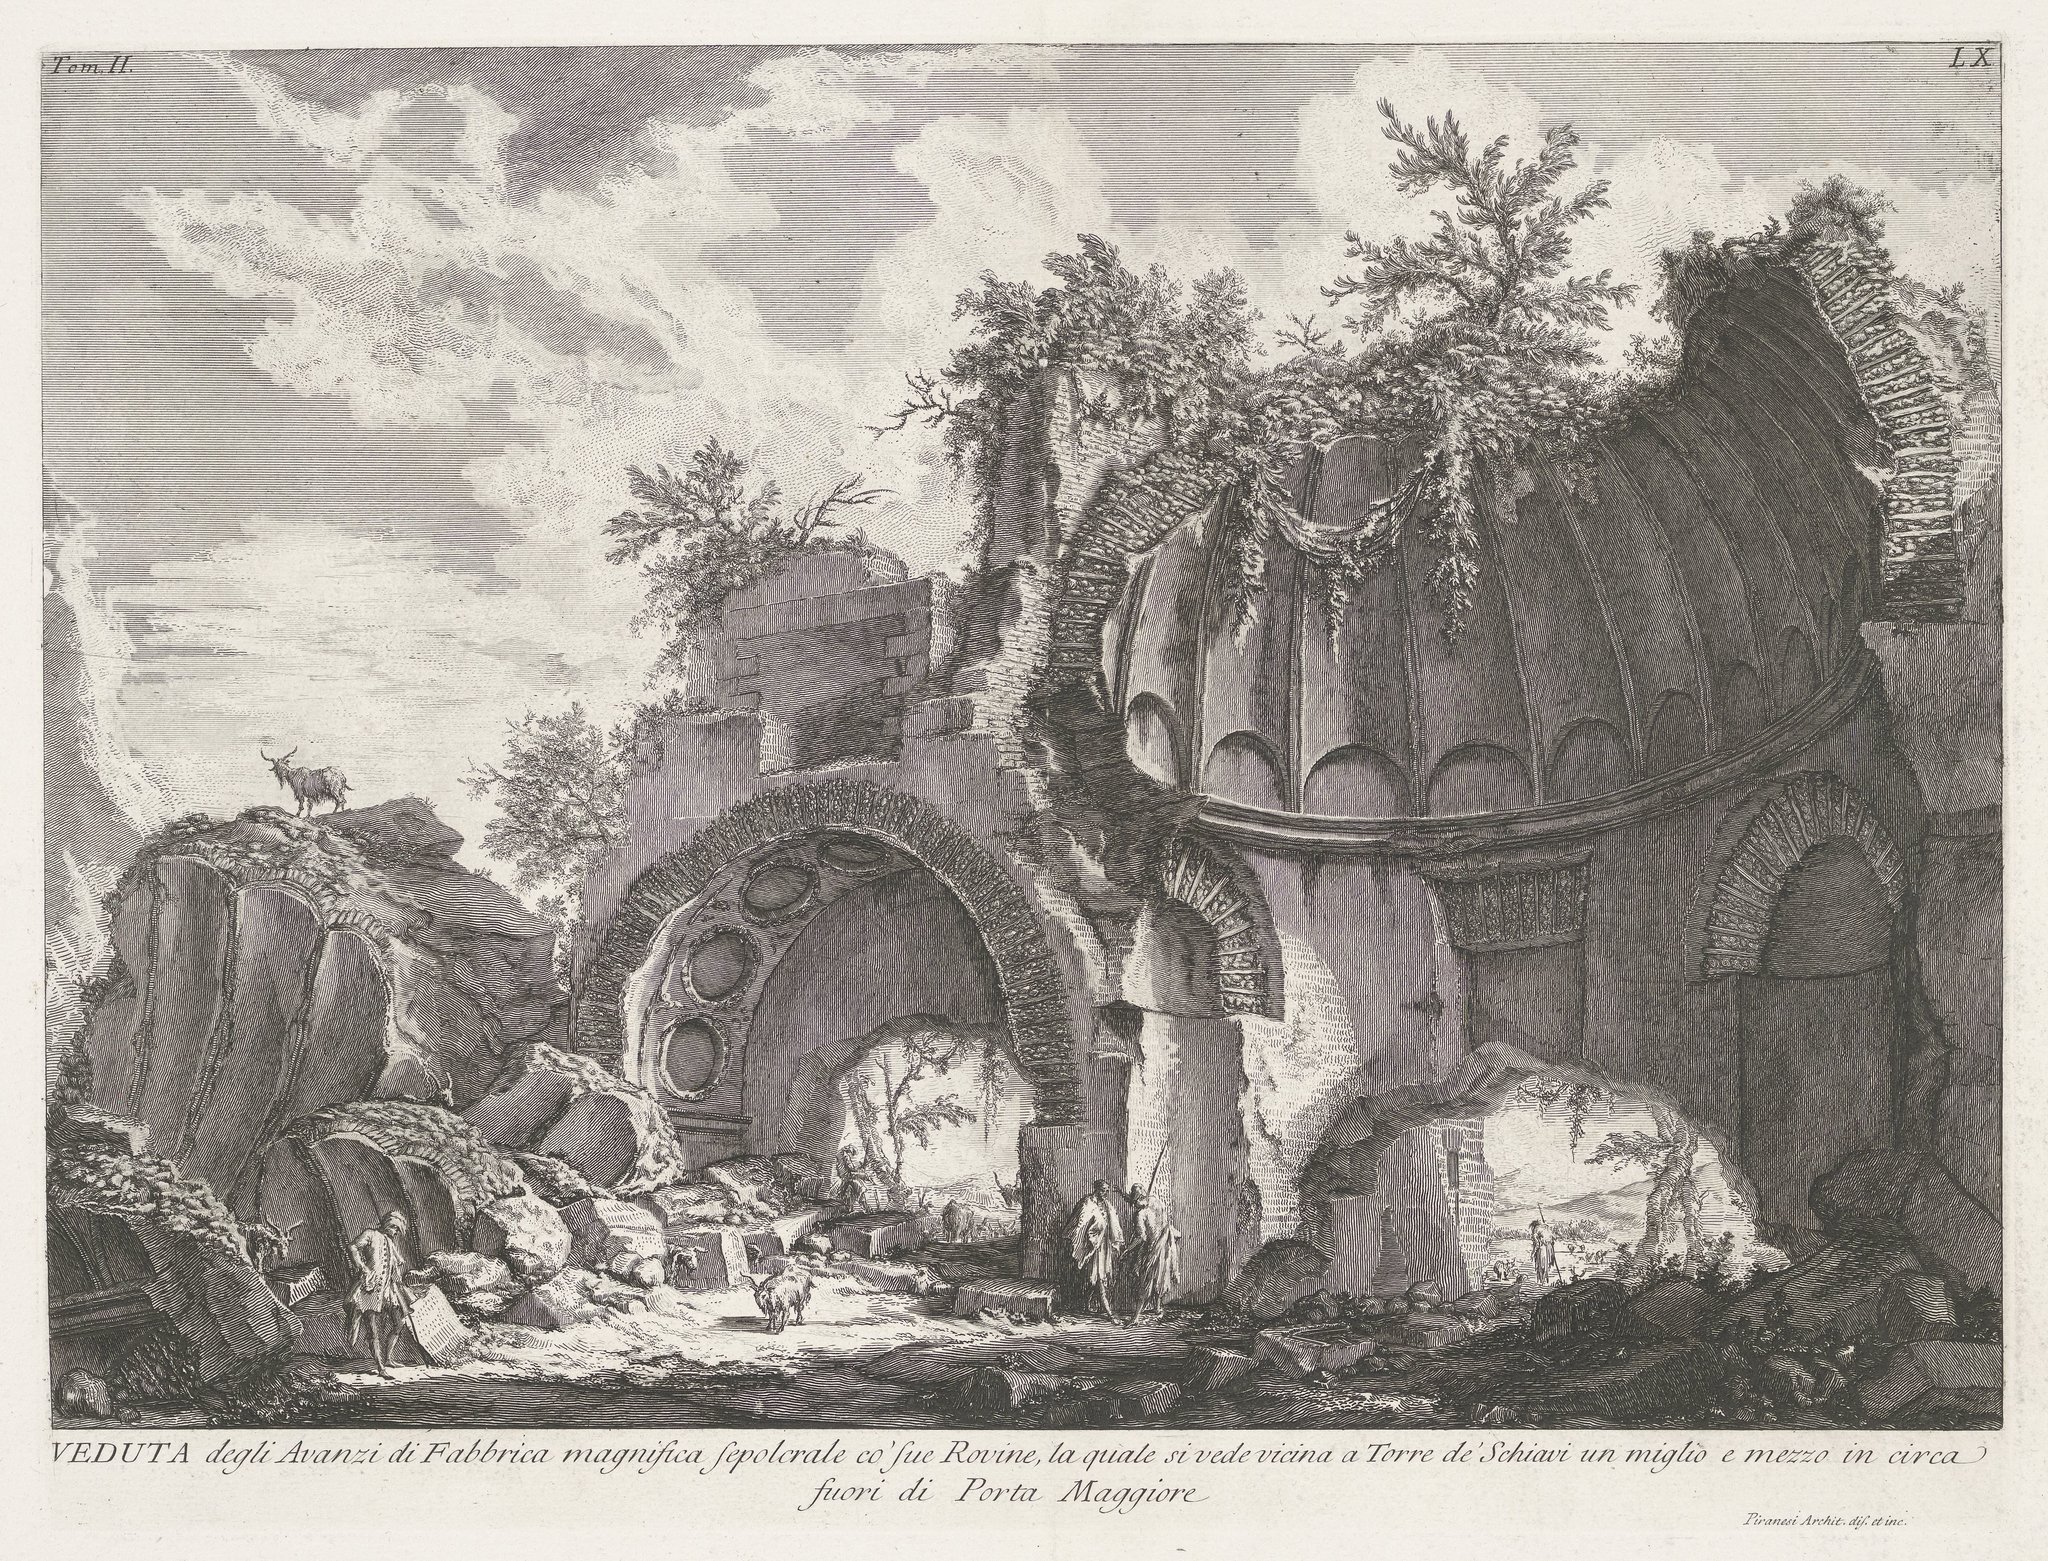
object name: print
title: Veduta degli Avanzi di Fabbrica magnifica sepolcrale co'sue Rovine, la quale se vede vicina a Torre de' Schiavi un miglio e mezzo in circa fuori di Porta Maggiore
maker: giovanni battista piranesi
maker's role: designer, draughtsman, print maker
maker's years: 1720-1778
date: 1756-1757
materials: paper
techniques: etching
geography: rome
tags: city-view, and landscape with man-made constructions, ruin of a building ~ architecture, landscape with ruins, grave, tomb, italy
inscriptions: collector's mark: Lugt 2228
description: Deze prent maakt deel uit van de serie 'Le Antichità Romane'. Piranesi deed meer dan acht jaar voorstudie voor deze 250 platen tellende serie die in vier volumes werd uitgegeven. Hij produceerde de prenten tussen ca. 1756 en 1757. De serie bevat ook prenten door of naar andere prentmakers, onder wie Francesco Bianchini en Girolamo Rossi.